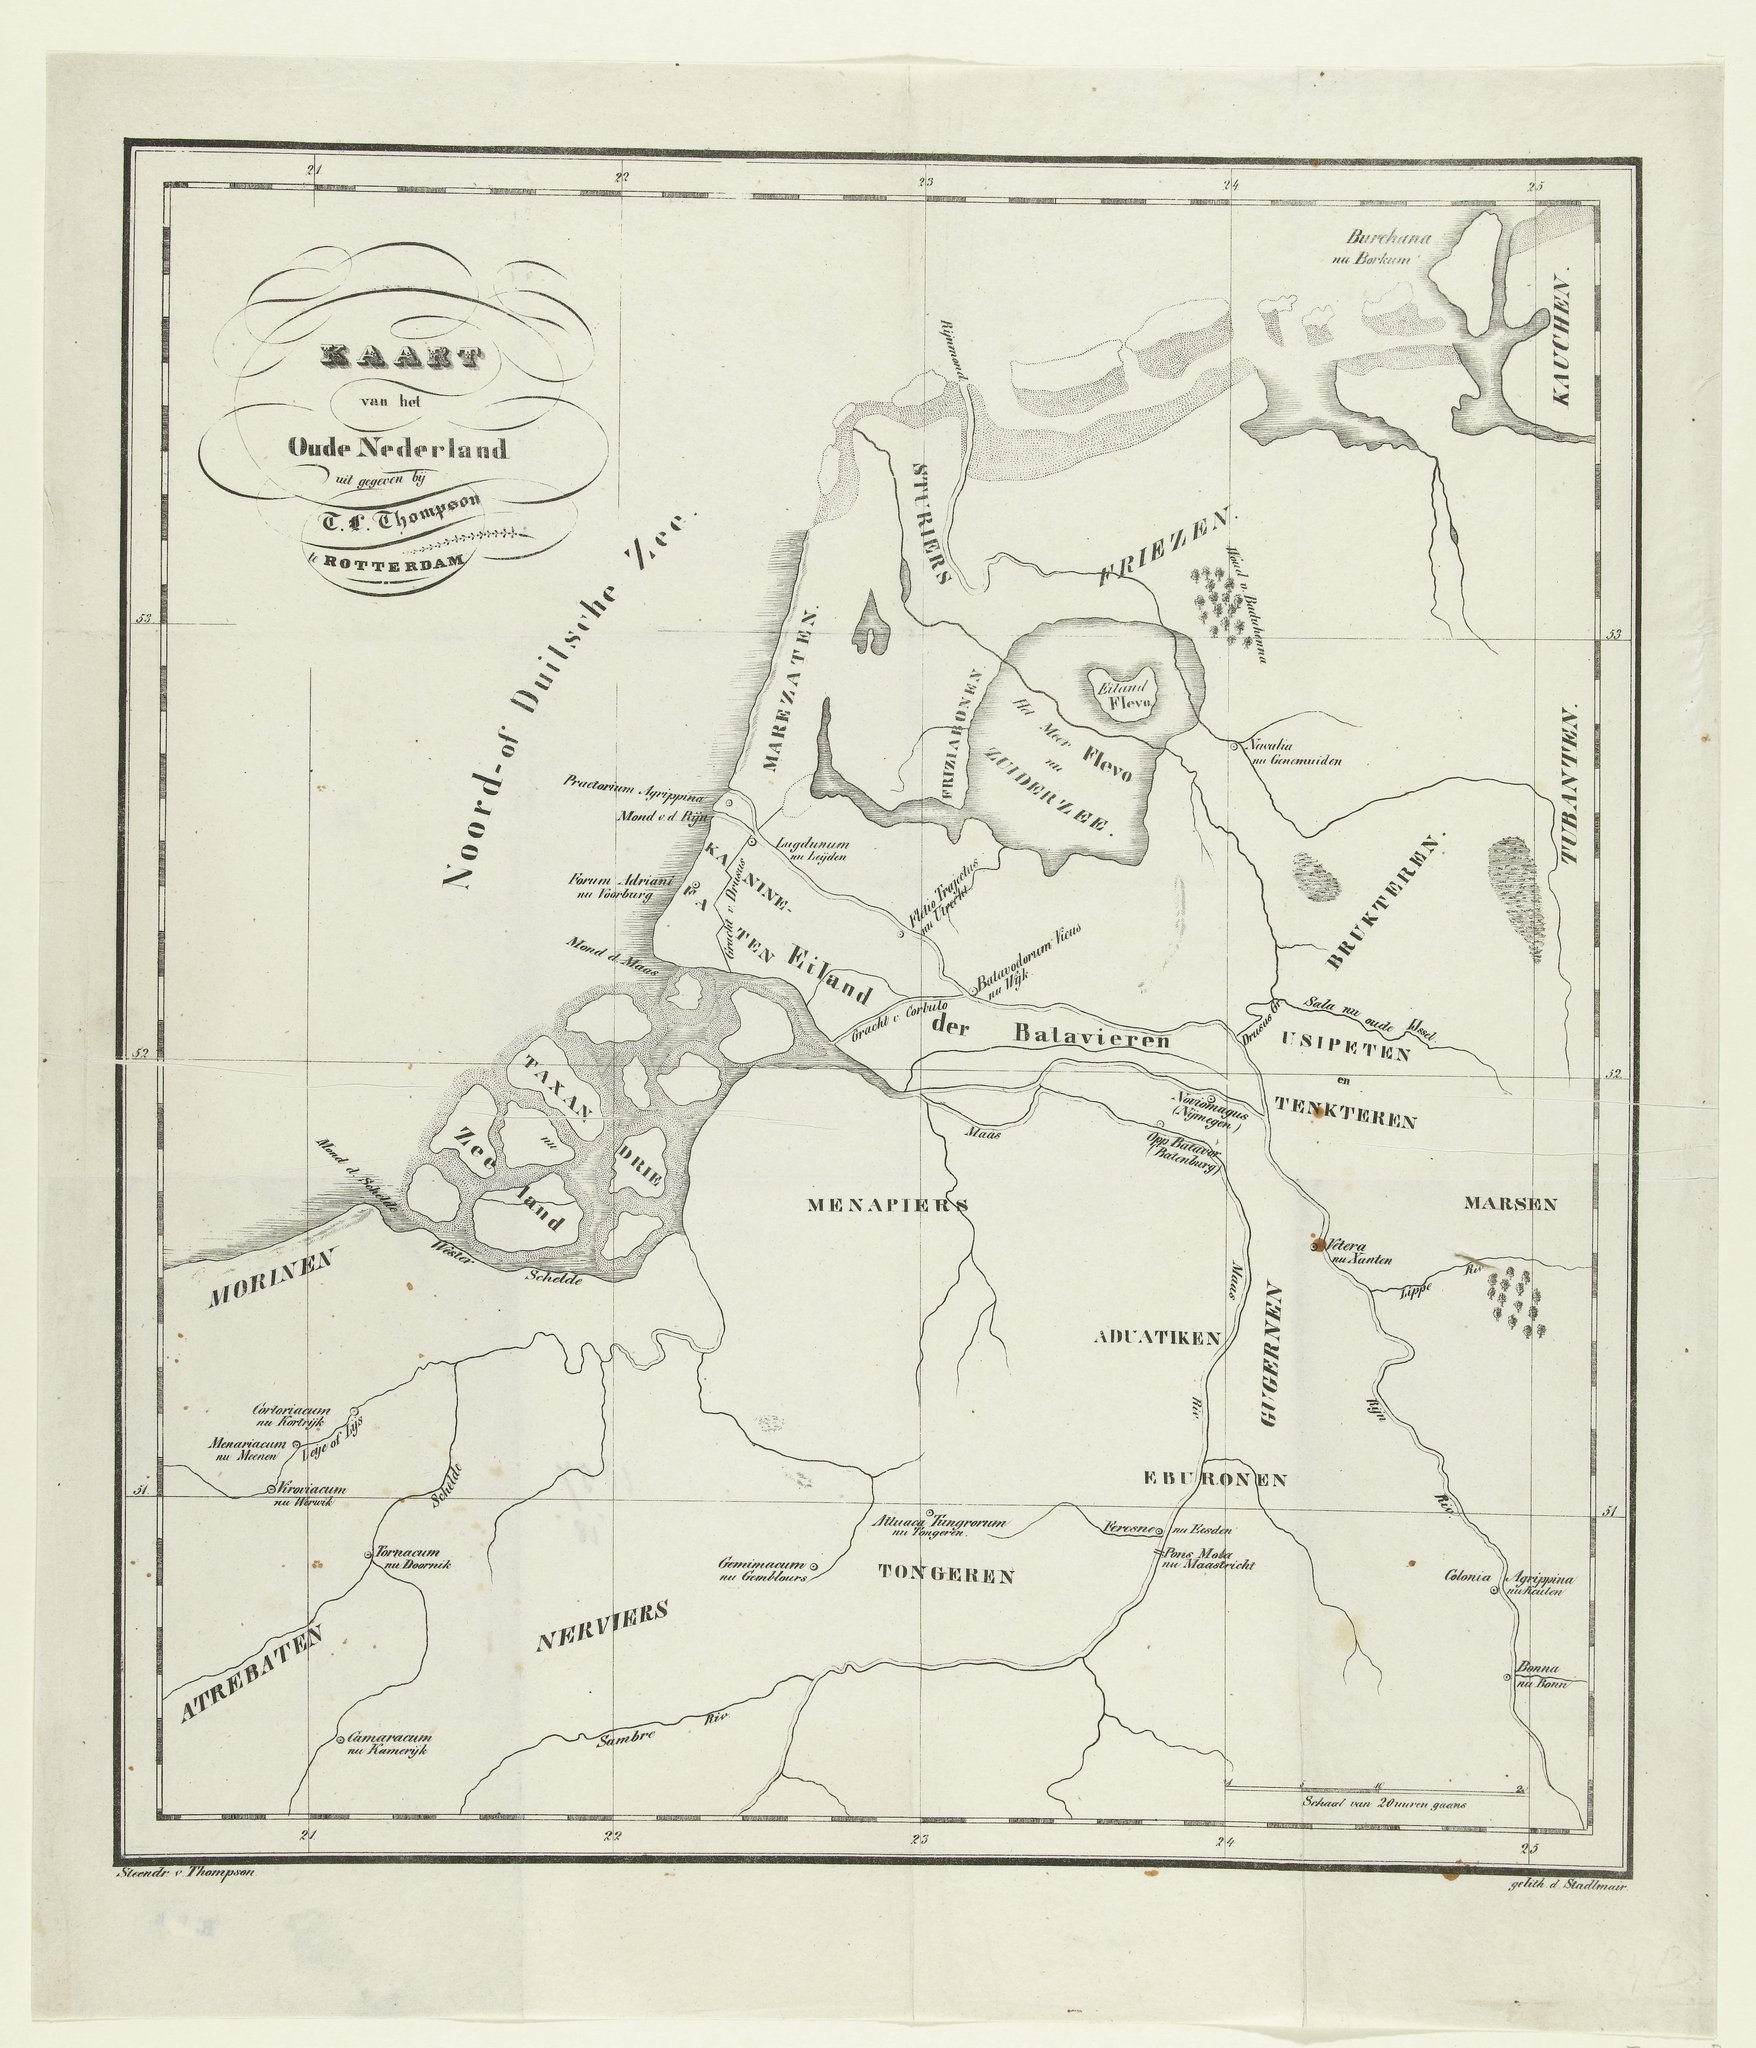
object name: print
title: Kaart van het Oude Nederland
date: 1830-1838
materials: paper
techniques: lithograph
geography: rotterdam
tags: maps of separate countries or regions, netherlands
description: Kaart van Nederland waarop is aangegeven welke volkeren of stammen in welke regio's woonden ten tijde van de Bataven.